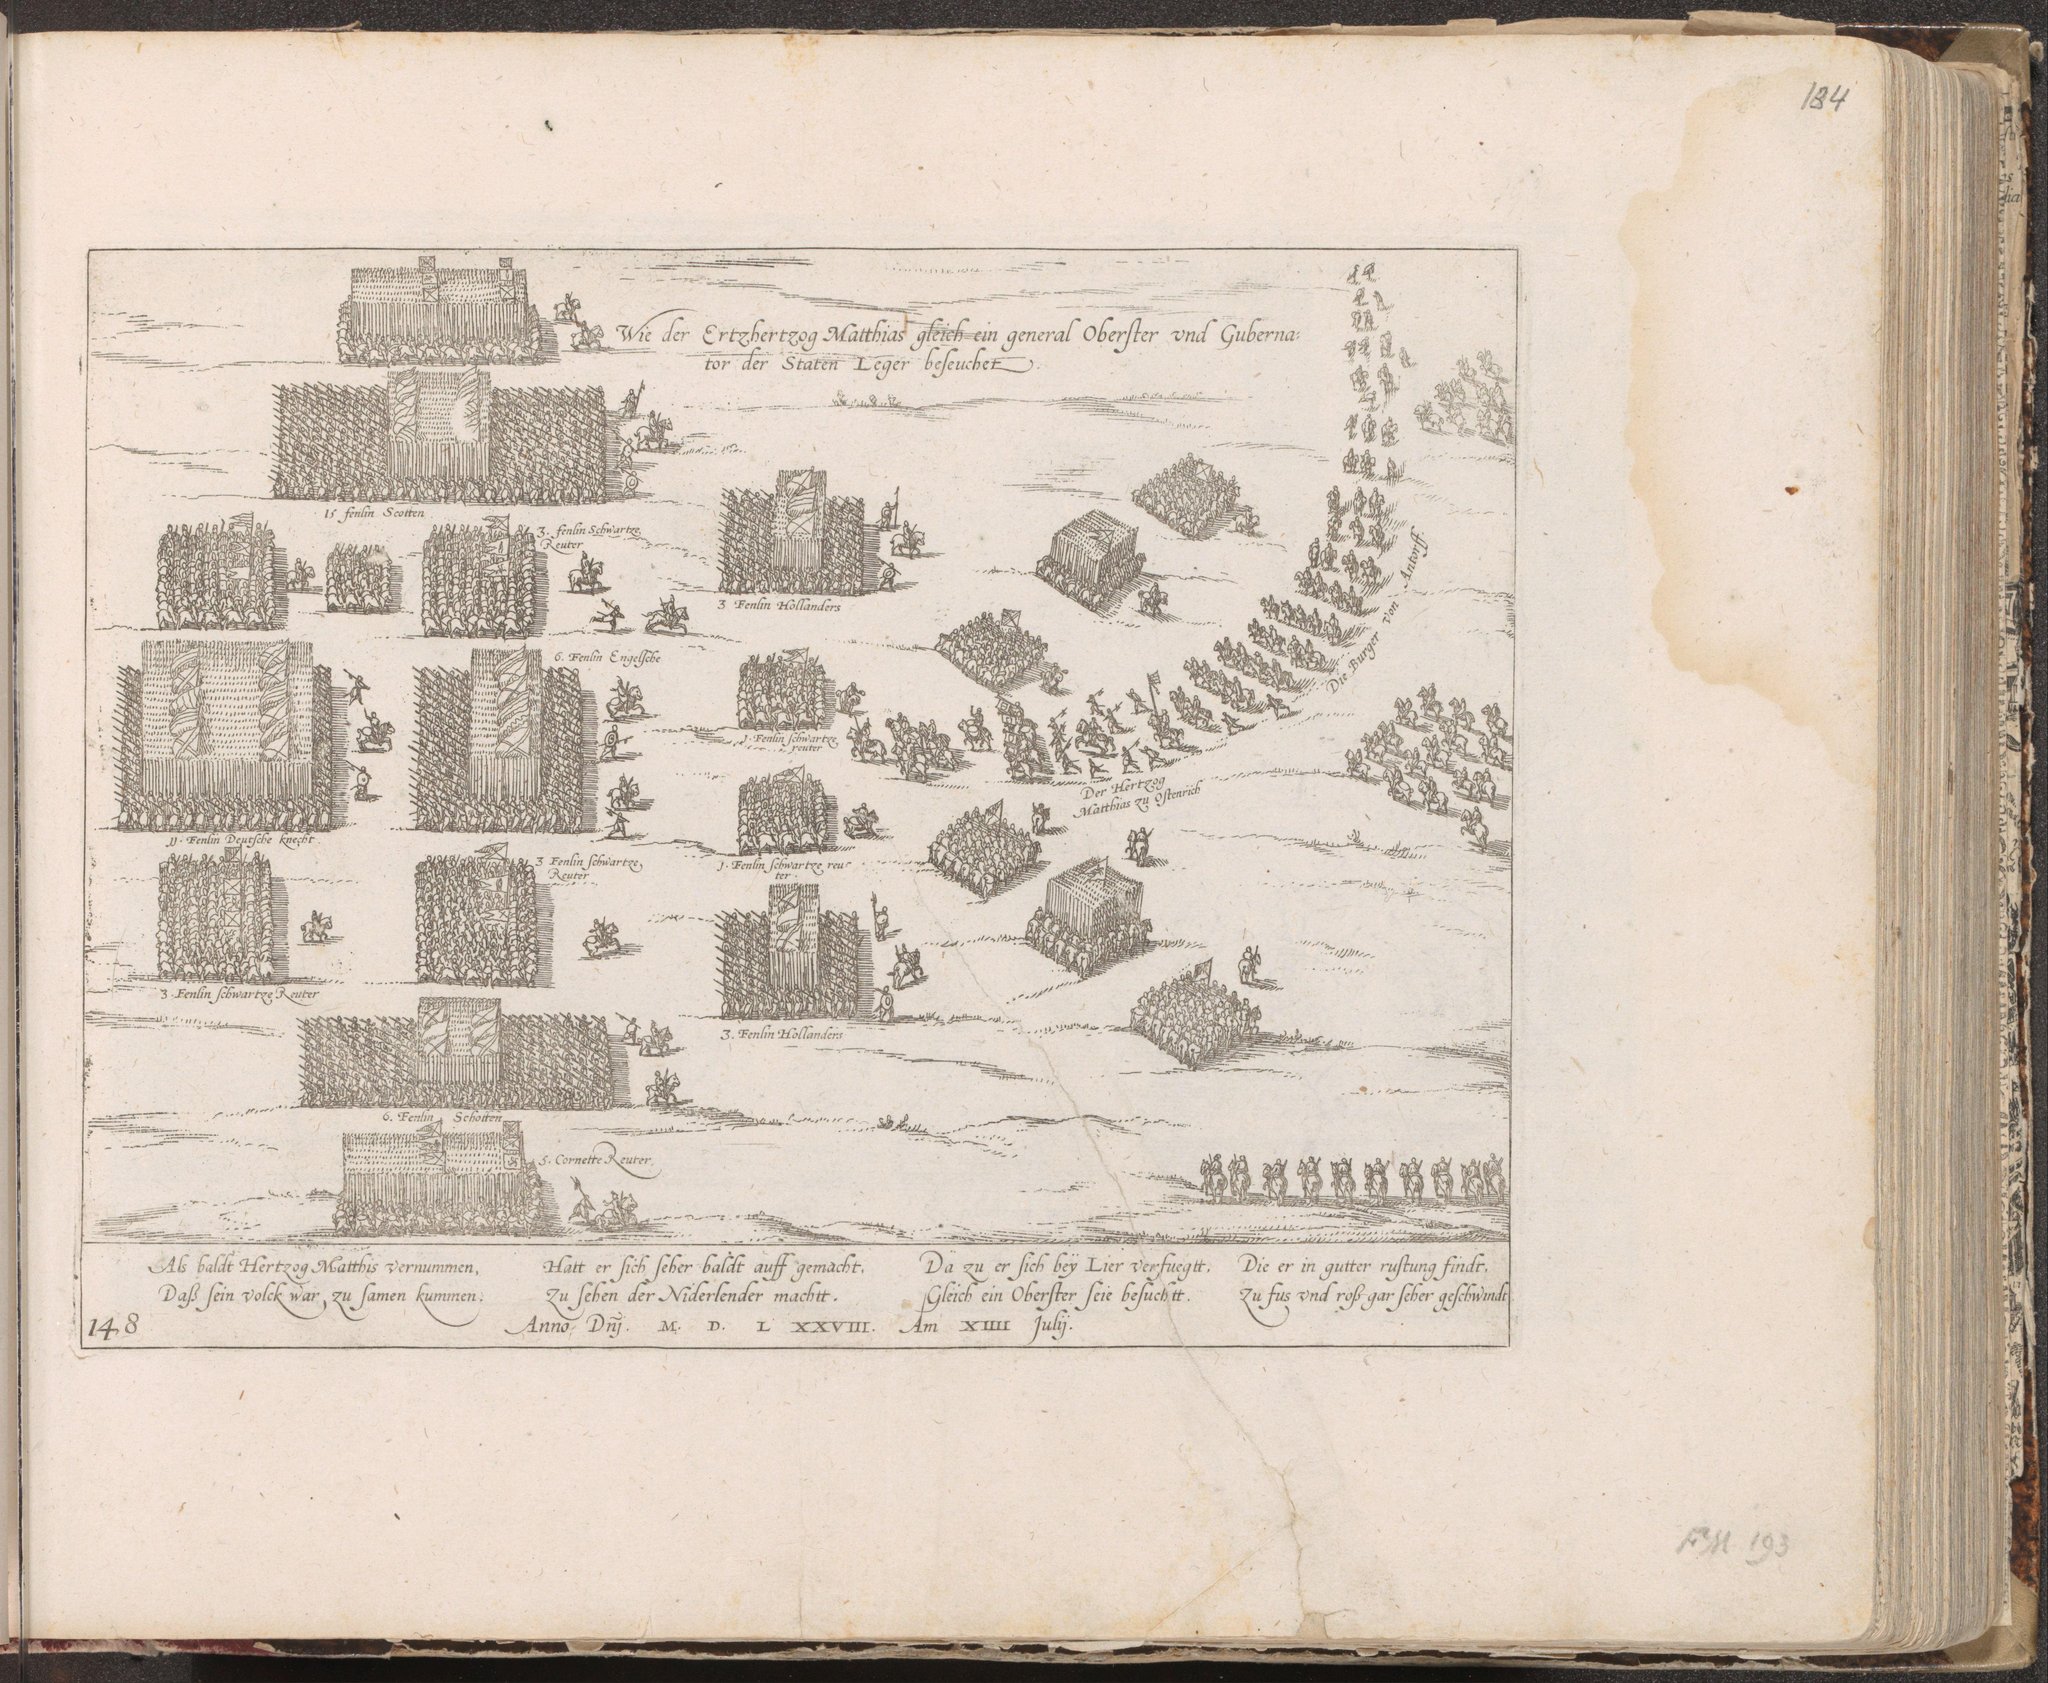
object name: print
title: Serie 8: Nederlandse Gebeurtenissen, 1577-1583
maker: frans hogenberg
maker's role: print maker, publisher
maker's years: 1538-1590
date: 1581-1585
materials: paper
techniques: etching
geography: cologne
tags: vienna, matthias van oostenrijk (rooms-duits keizer), review, inspection (of company, unit, troop), lierre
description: Bezoek door aartshertog Matthias aan het Staatse leger bij Lier, 14 juli 1578. Met onderschrift van 8 regels in het Duits. Linksonder genummerd: 148. De prent maakt deel uit van een album.